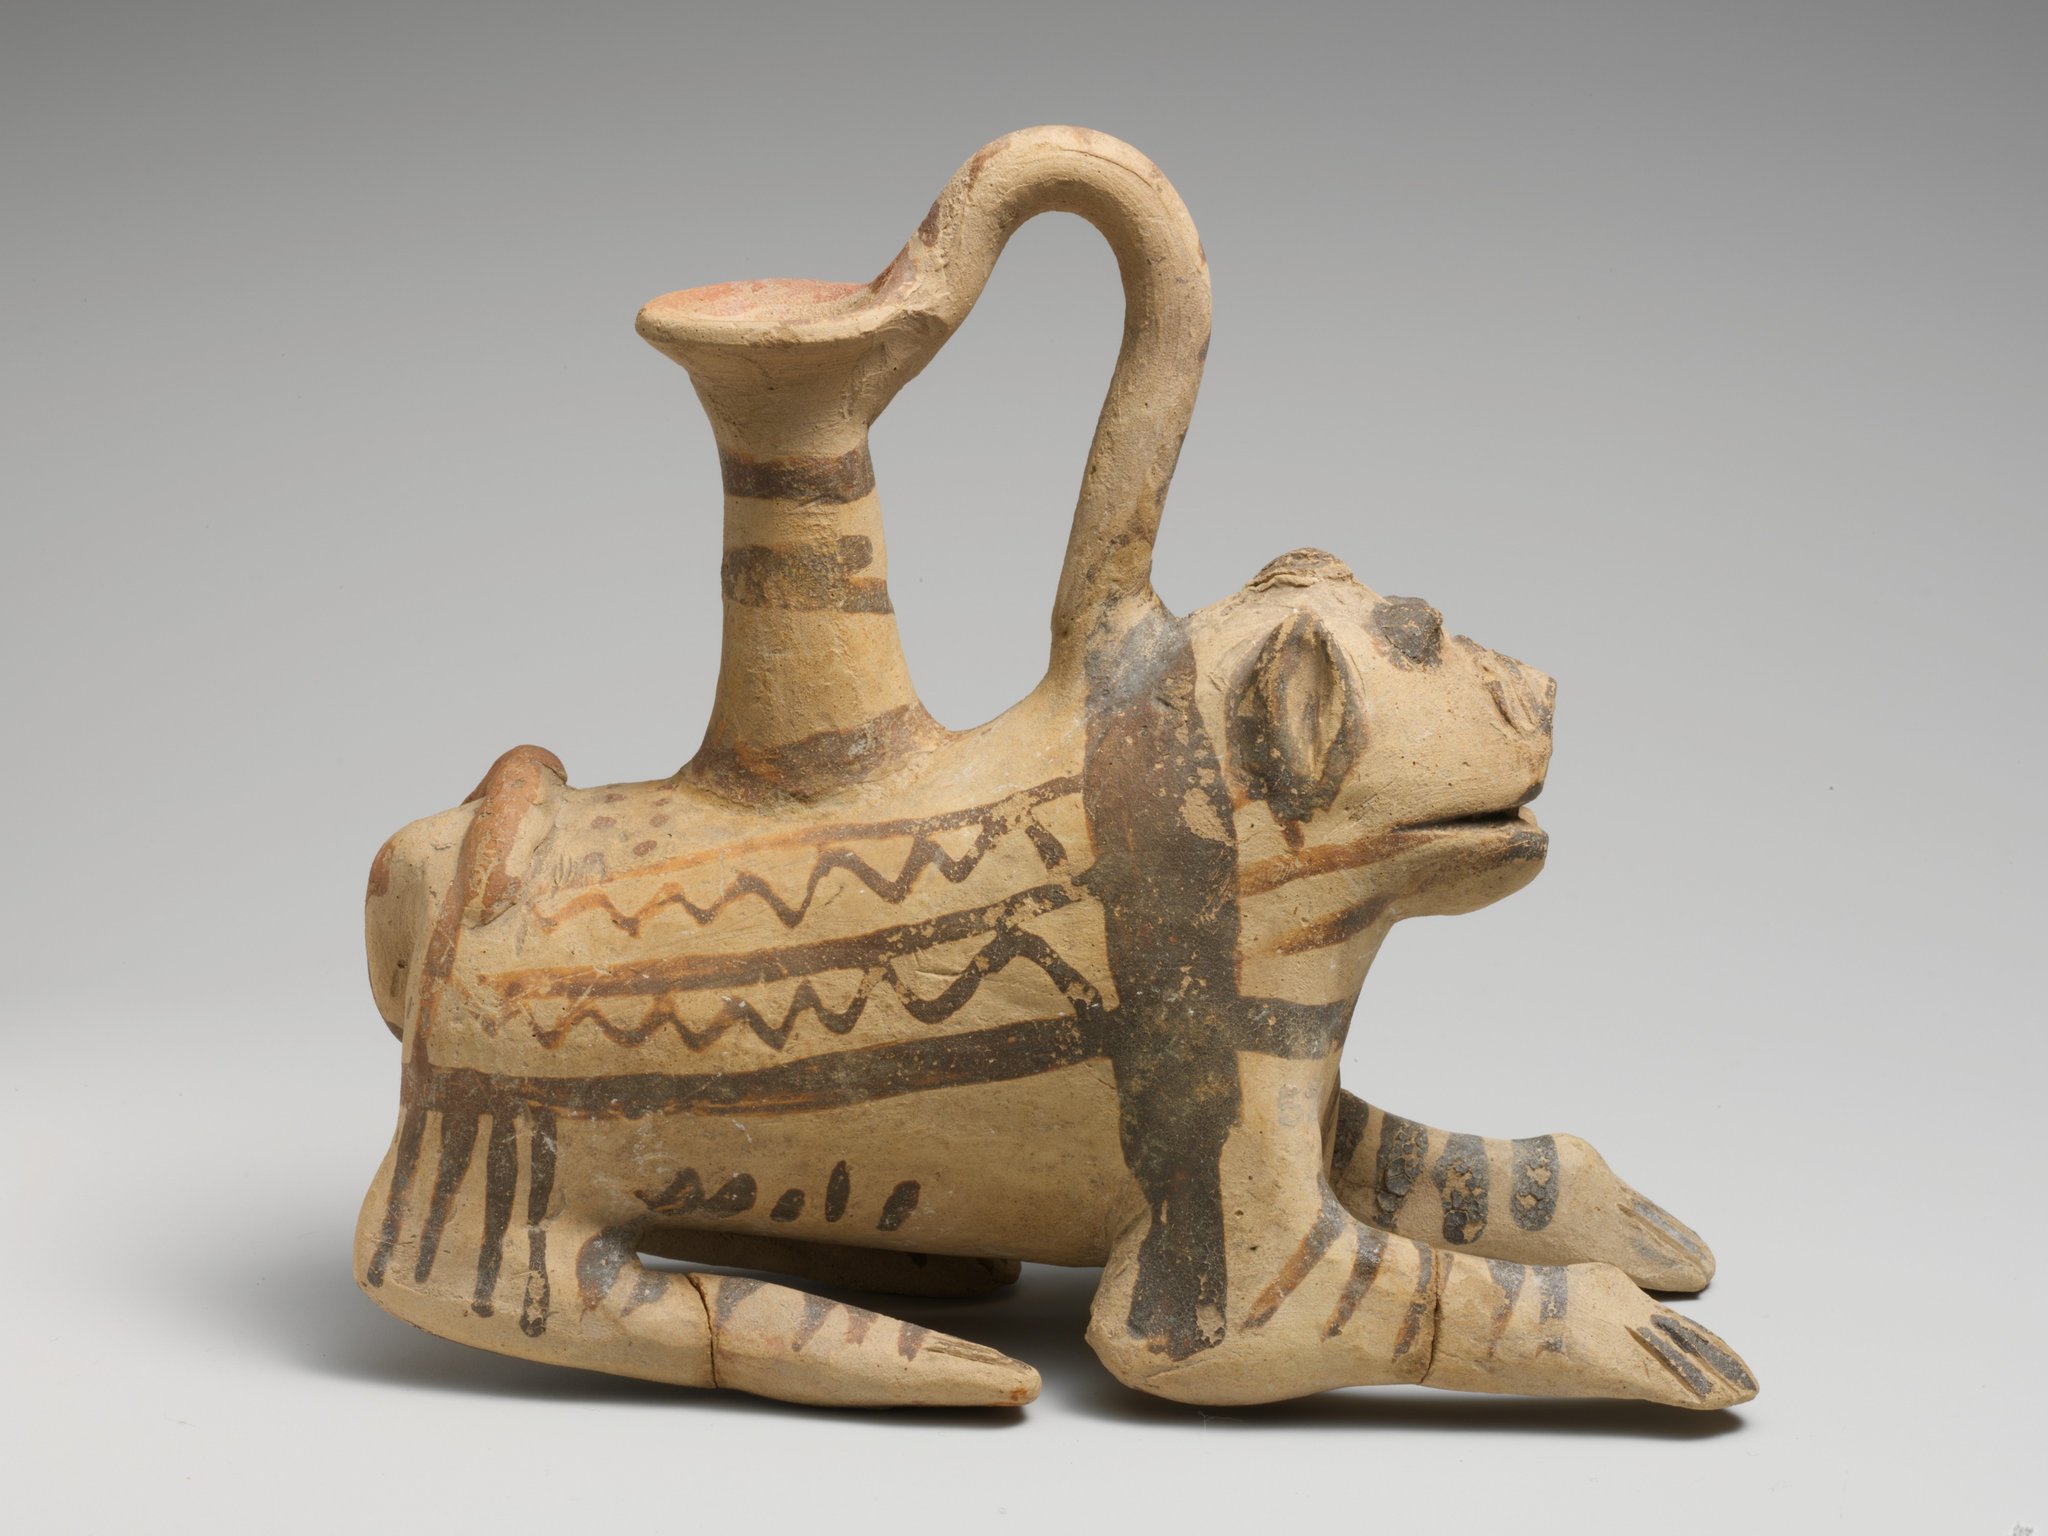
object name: askos in the form of a lion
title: Terracotta askos (vessel) in the form of a lion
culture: cypriot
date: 1200-1050 BCE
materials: terracotta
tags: lions